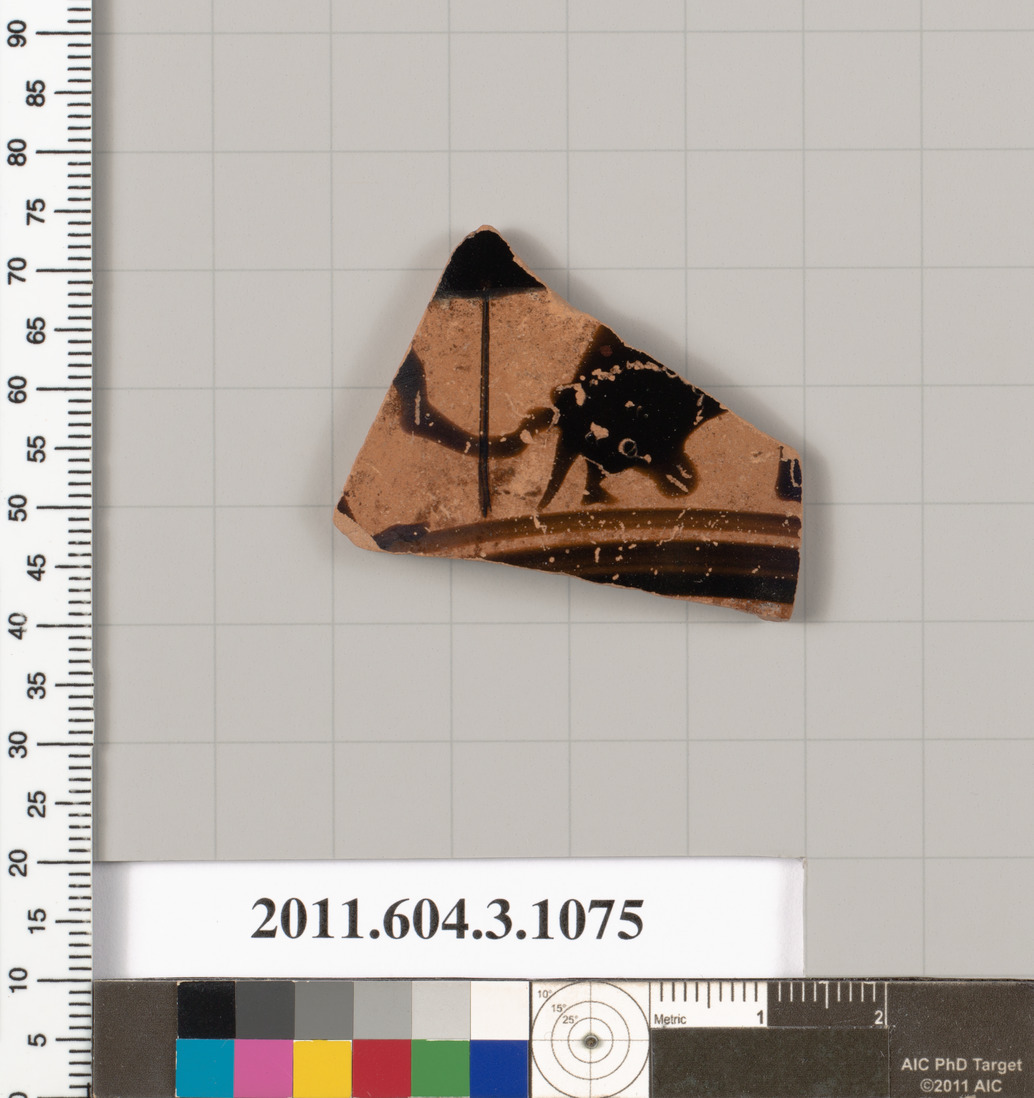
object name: mastoid fragment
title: Terracotta fragment of a mastoid (drinking cup with narrow base)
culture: greek, attic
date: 534-468 BCE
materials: terracotta